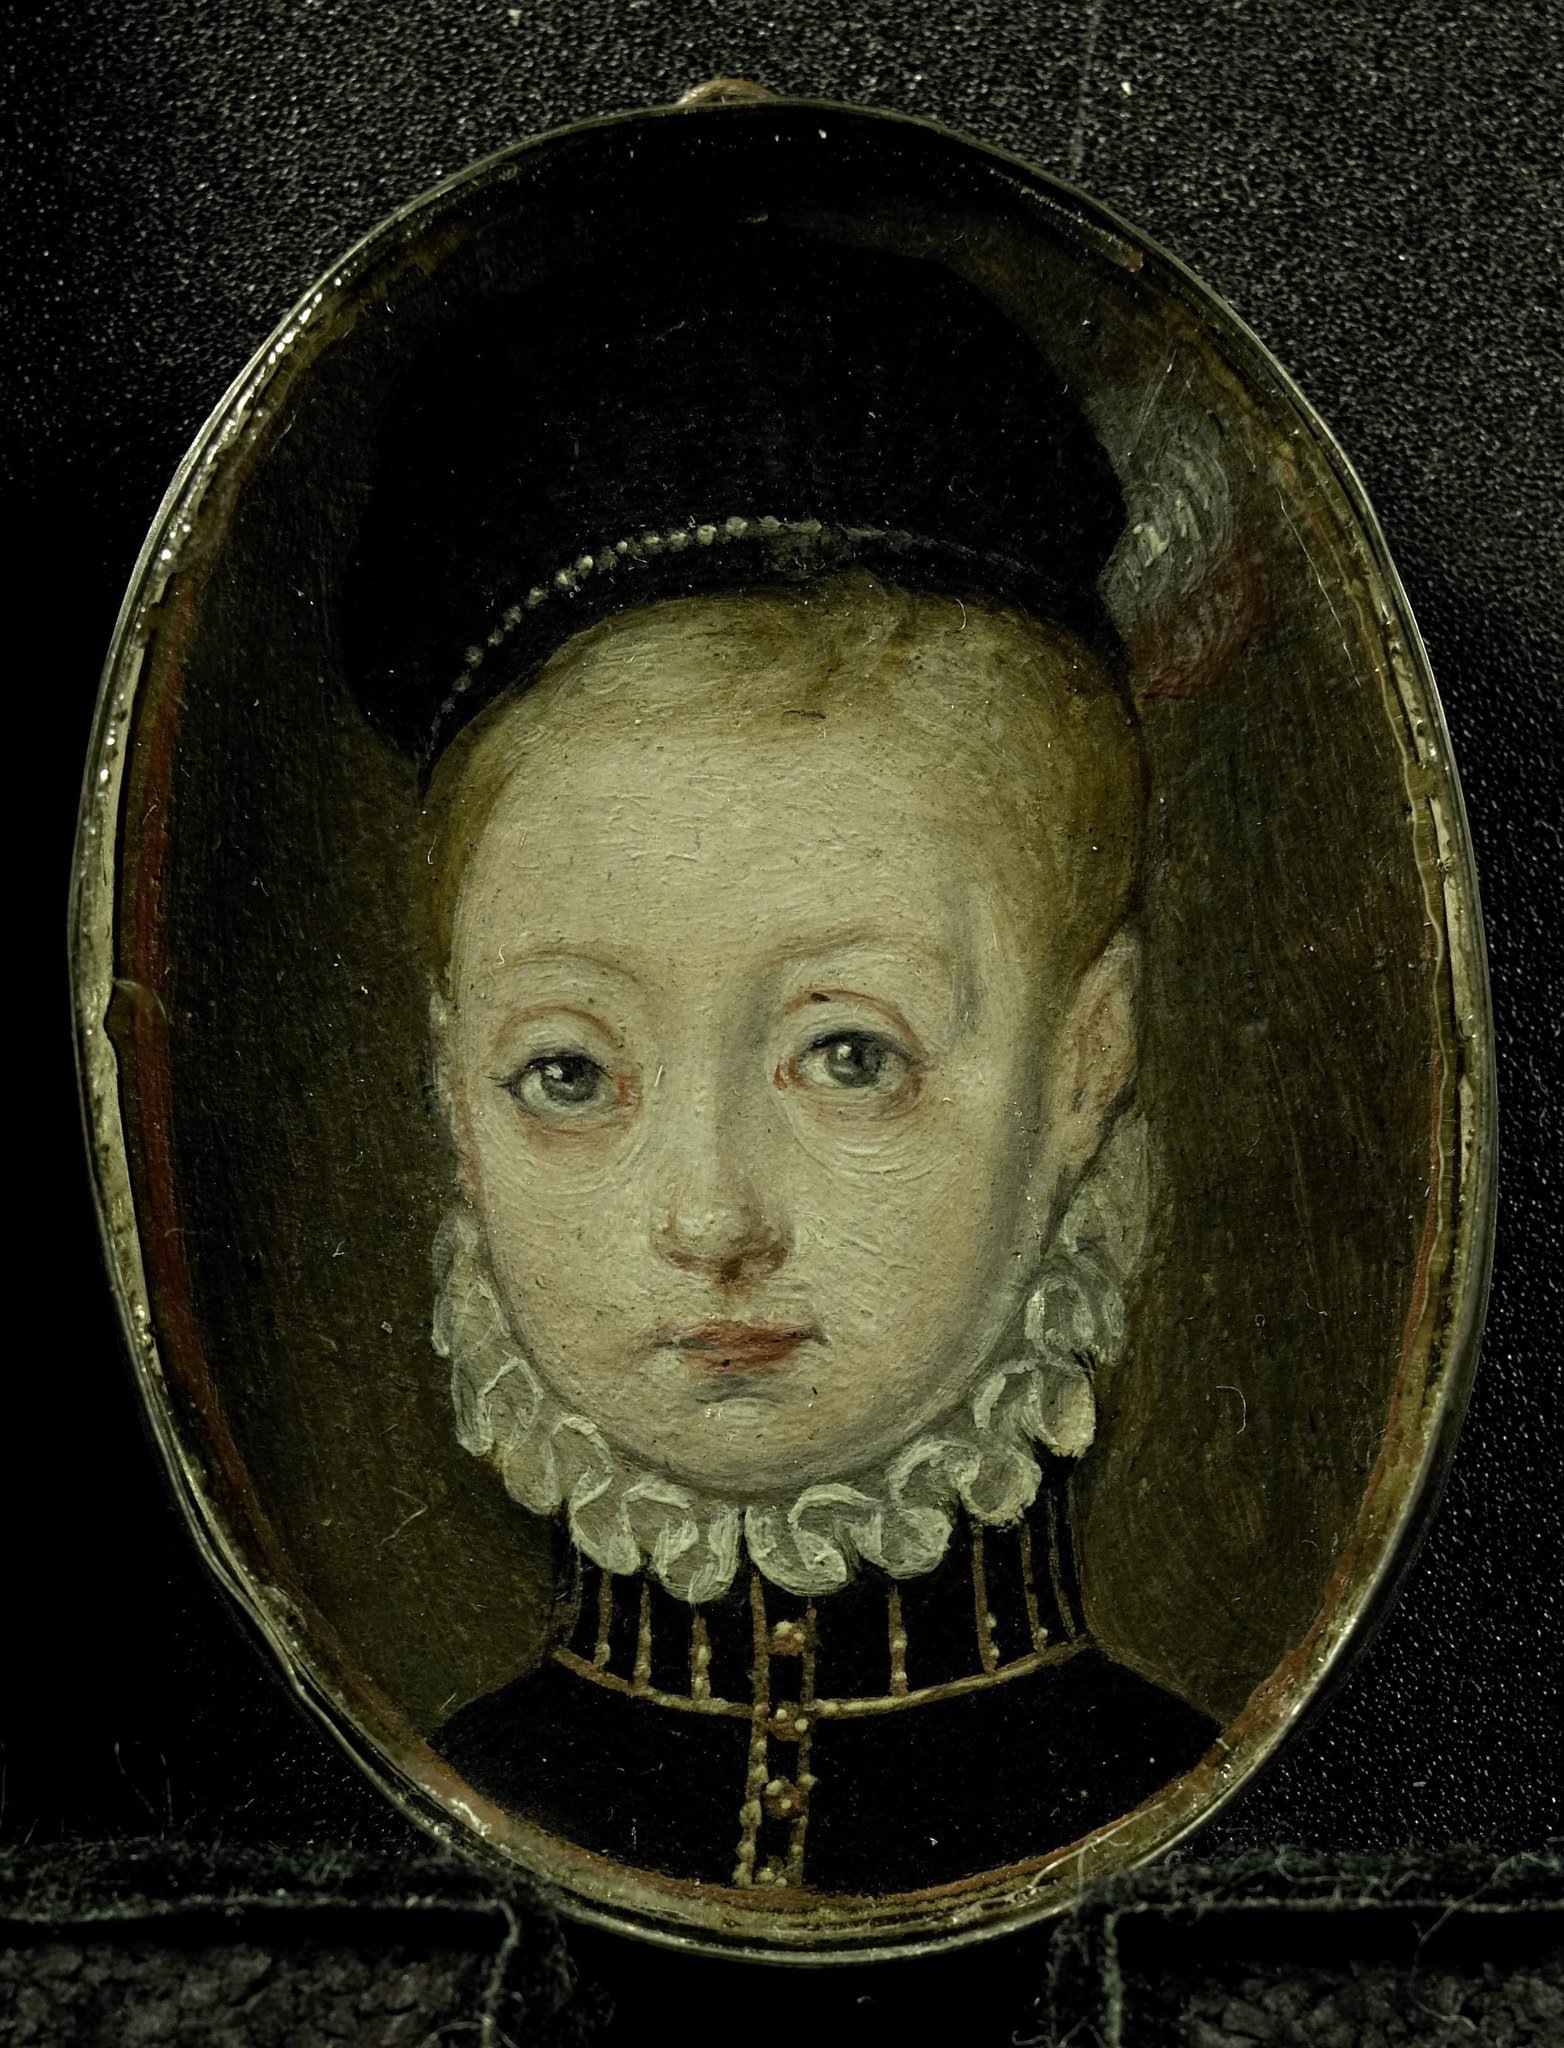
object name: painting, miniature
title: Jacobus I (1556-1625), de latere koning van Engeland, als kind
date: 1574-1598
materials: cardboard, glass, silver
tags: jacobus i (koning van engeland)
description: Portret van Jacobus I (1556-1625), de latere koning van Engeland, als kind. Buste, aanziend. Naar het portret van Arnold van Bronckorst uit 1574 in Edinburgh. Onderdeel van de collectie portretminiaturen.